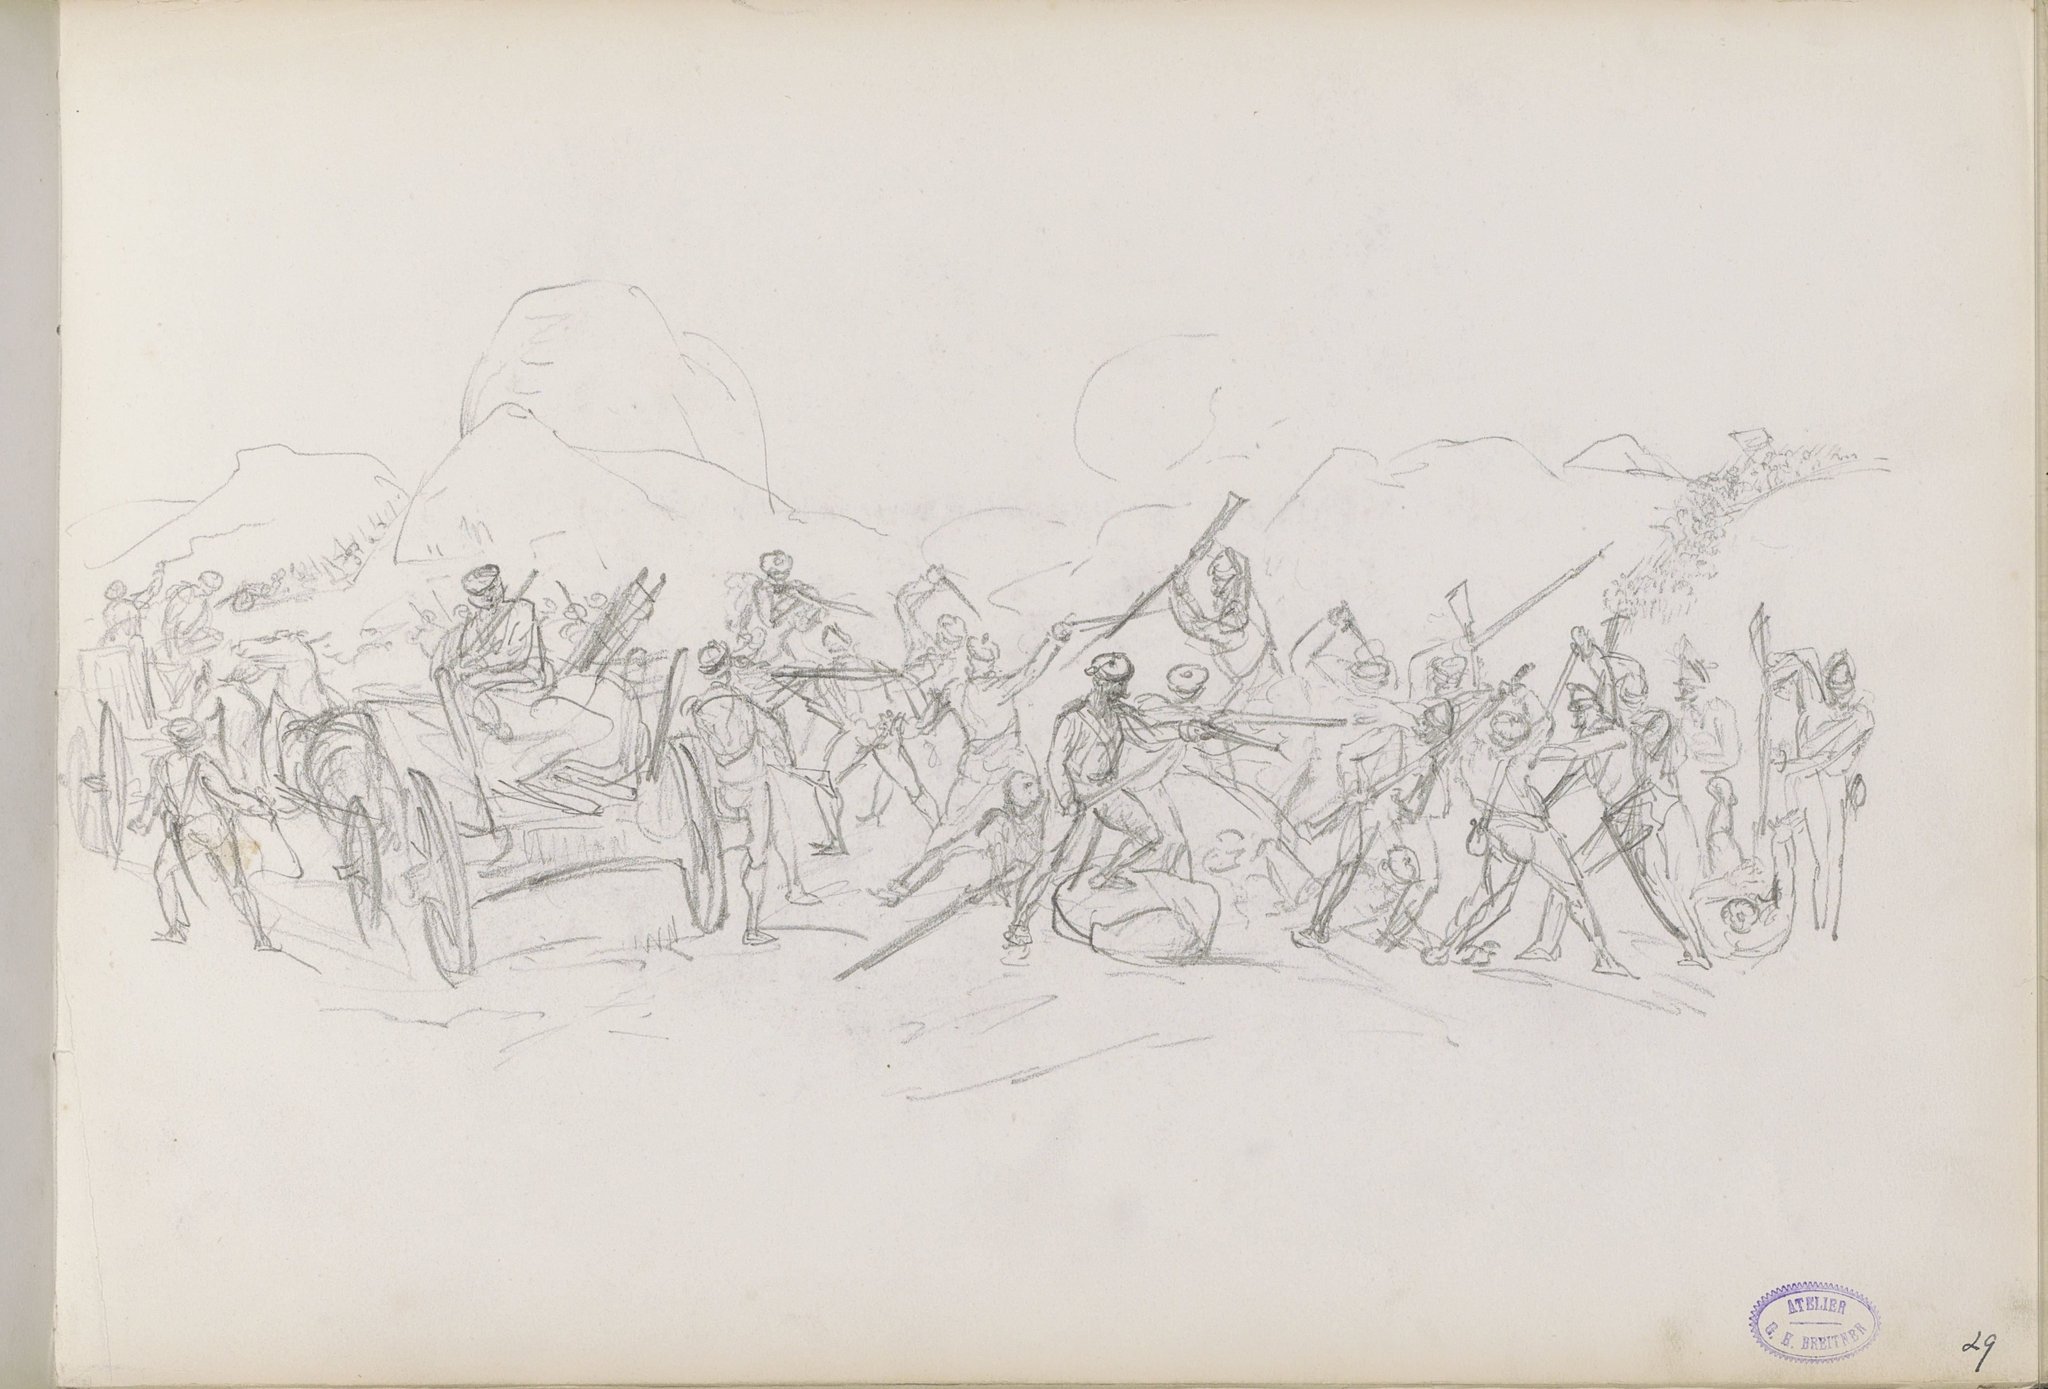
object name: sketchbook leaf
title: Strijdende soldaten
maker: george hendrik breitner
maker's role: draughtsman, painter, print maker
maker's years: 1857-1923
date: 1873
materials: paper, pencil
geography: rotterdam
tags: division of armed forces (+ during the battle), division of armed forces (+ infantry), four-wheeled, animal-drawn vehicle, e.g.: cab, carriage, coach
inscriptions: workshop stamp: Lugt 291d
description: Links wagens. Blad 29 recto uit een schetsboek met 25 bladen.